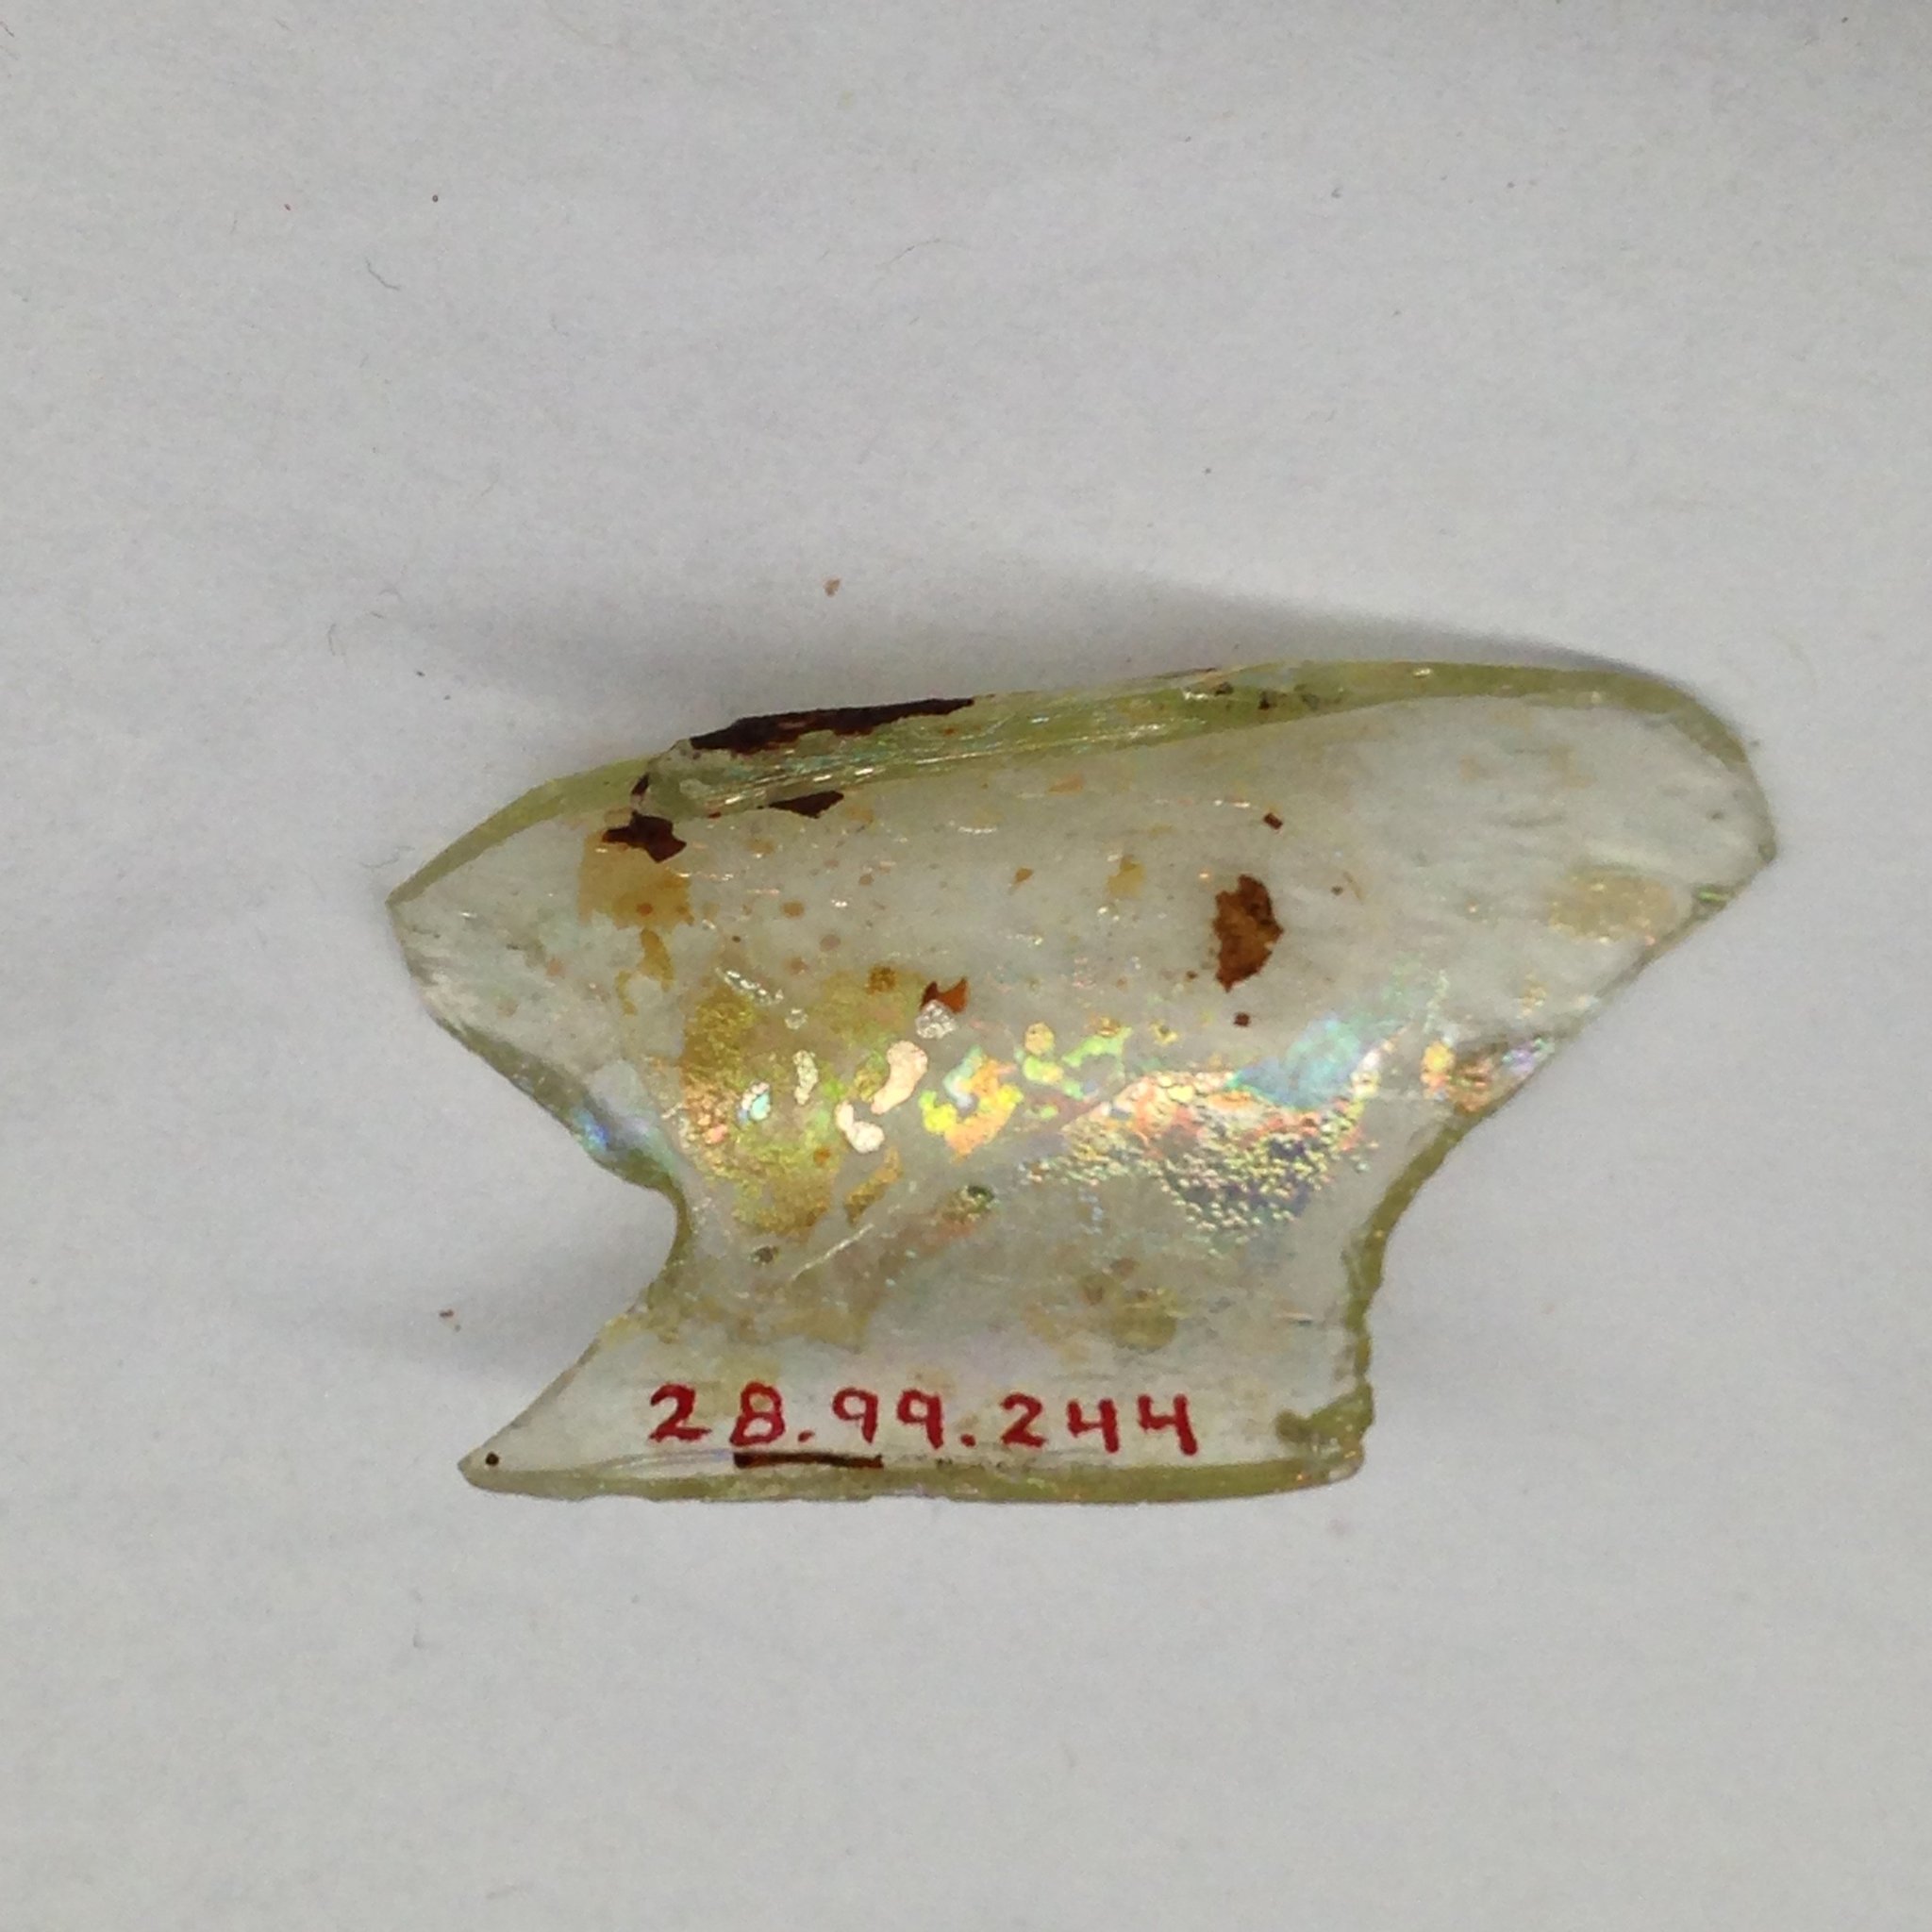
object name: fragment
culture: european or middle eastern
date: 1150-1250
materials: ceramic, glass